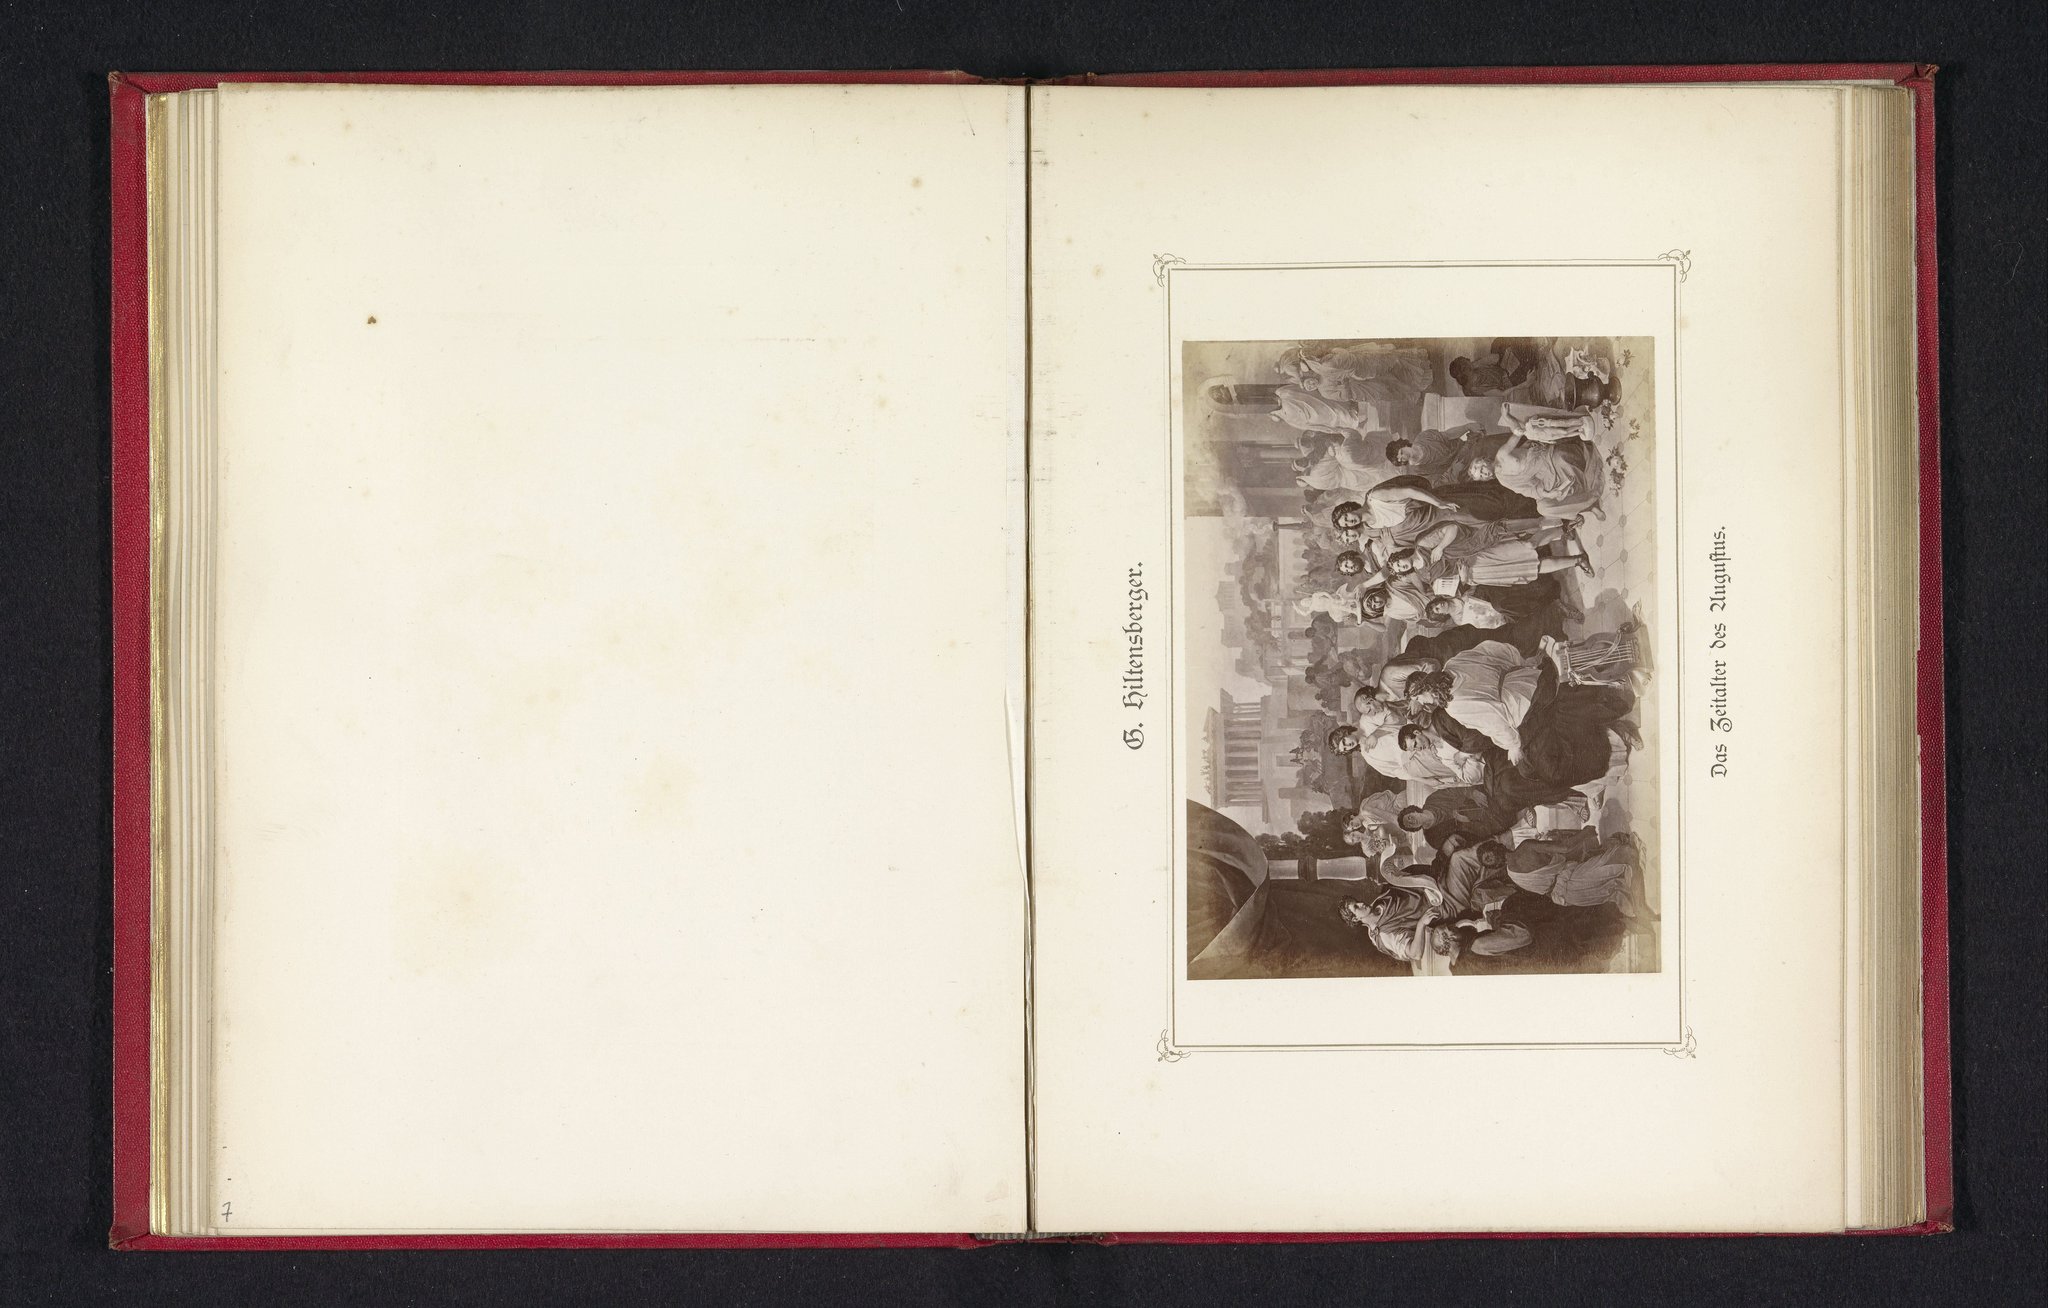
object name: page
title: Fotoreproductie van een schilderij, voorstellende keizer Augustus en zijn hofhouding te Rome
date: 1875-1880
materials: photographic support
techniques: albumen print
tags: family of a ruler, and court, (story of) augustus, the roman emperor